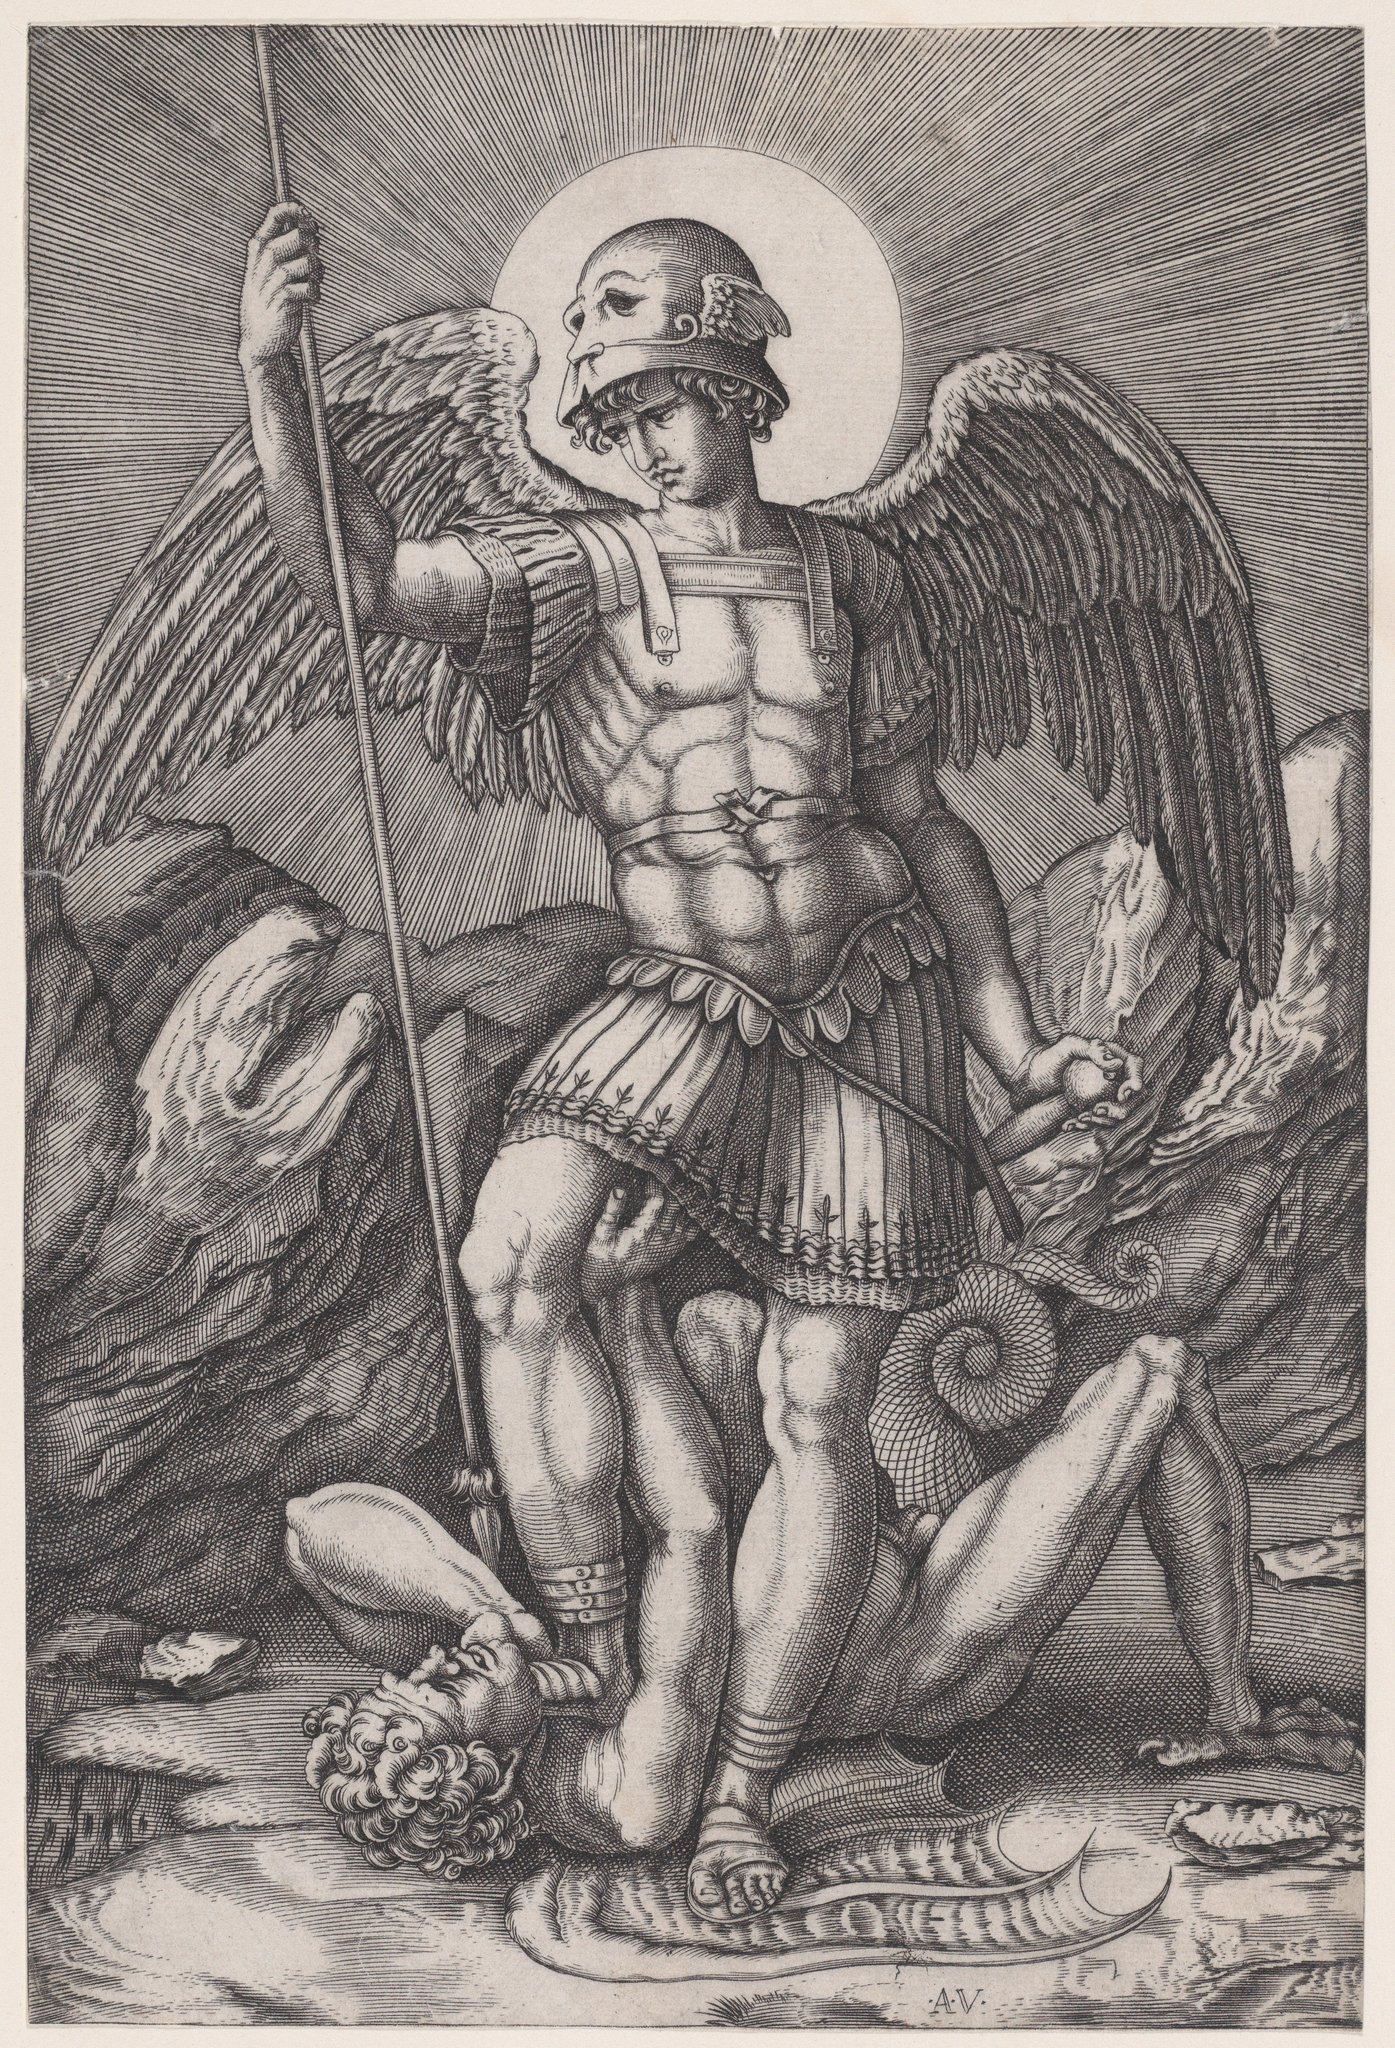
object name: print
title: Saint Michael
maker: agostino veneziano (agostino dei musi)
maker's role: artist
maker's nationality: italian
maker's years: 1490-1536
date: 1514-1516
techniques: engraving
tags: men,saint michael